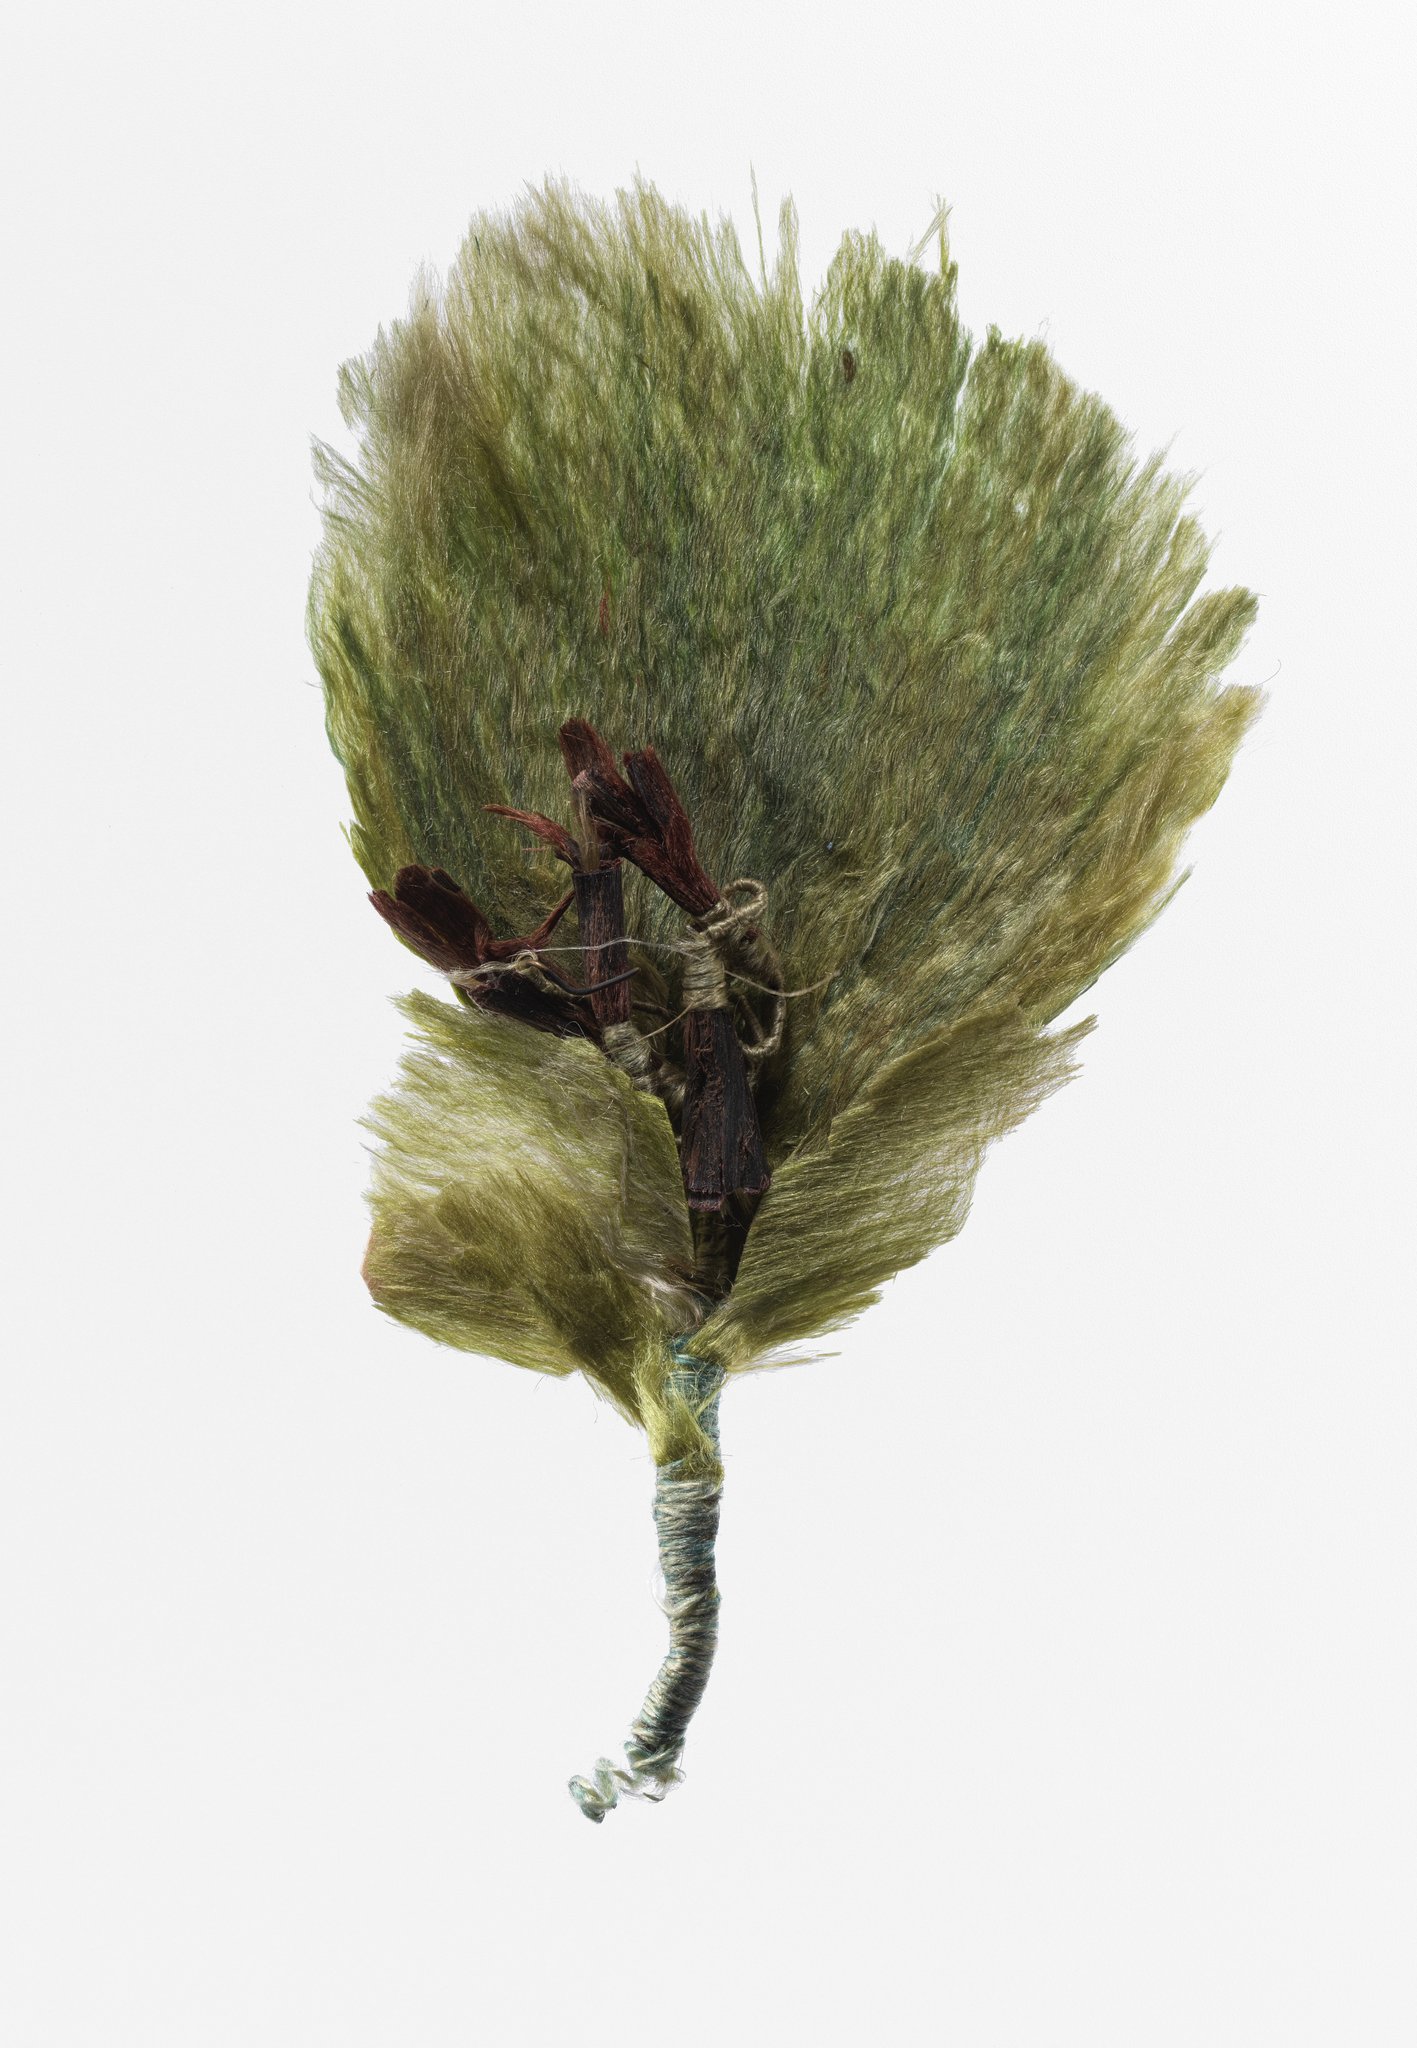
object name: boutonnière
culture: british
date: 1625-1649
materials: silk